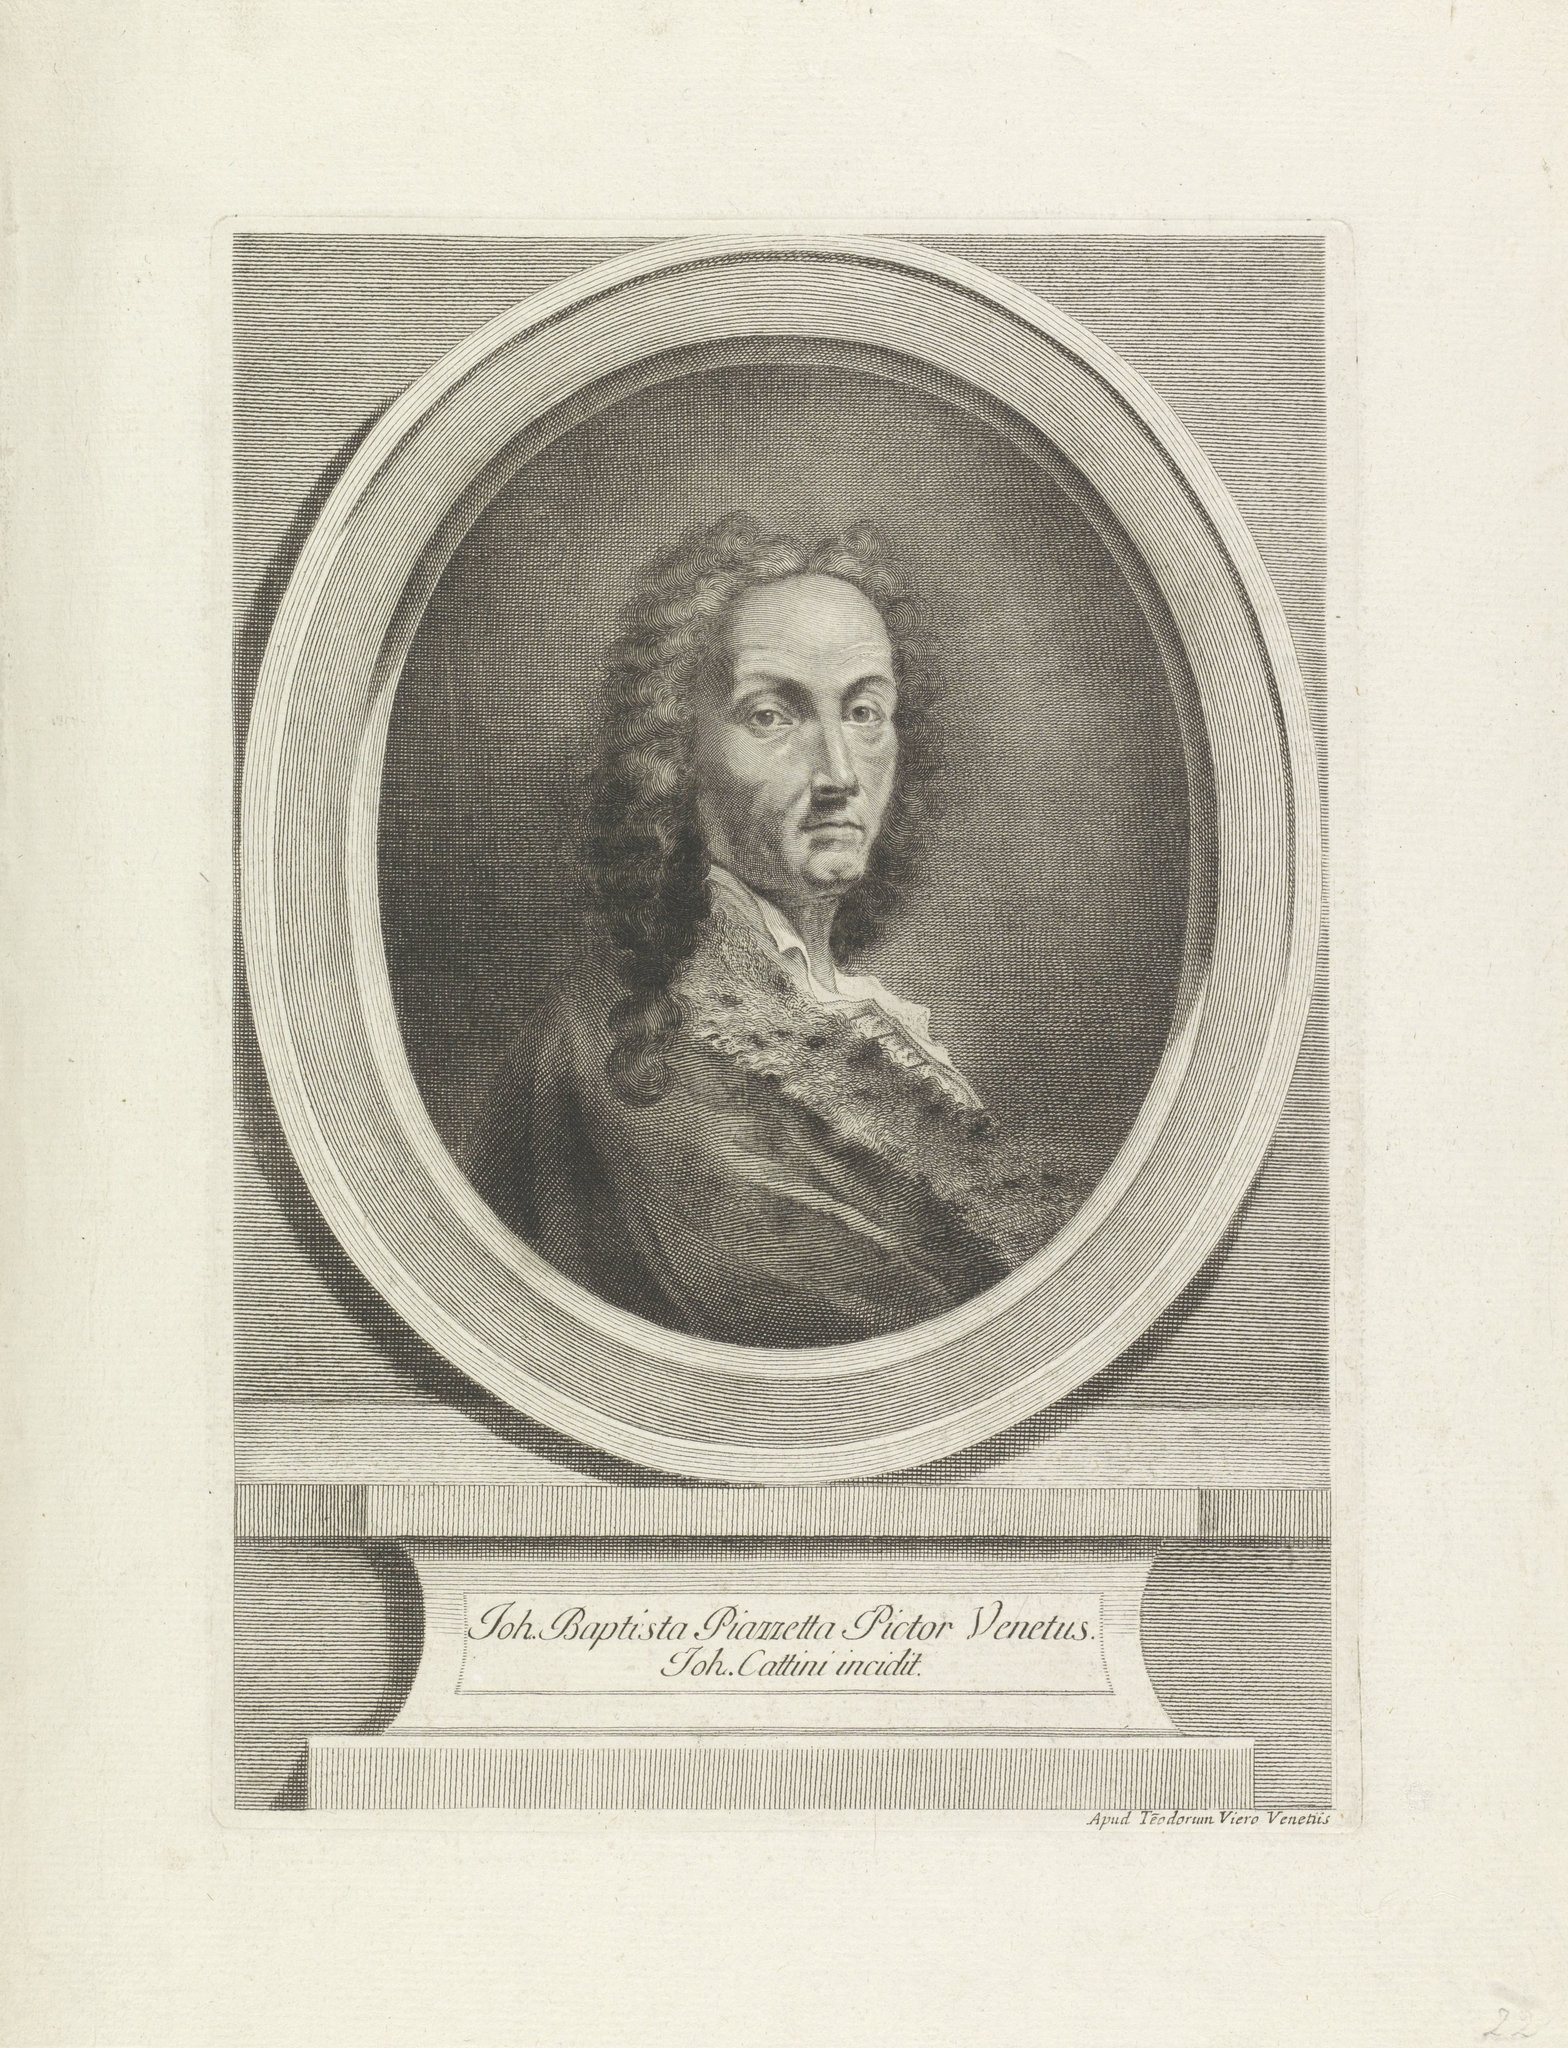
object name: print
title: Portret van schilder Giovanni Battista Piazzetta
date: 1735-1800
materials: paper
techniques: engraving, etching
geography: venice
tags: painter, draughtsman, giovanni battista piazzetta, historical persons, portrait, self-portrait of artist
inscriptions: collector's mark: Lugt 240